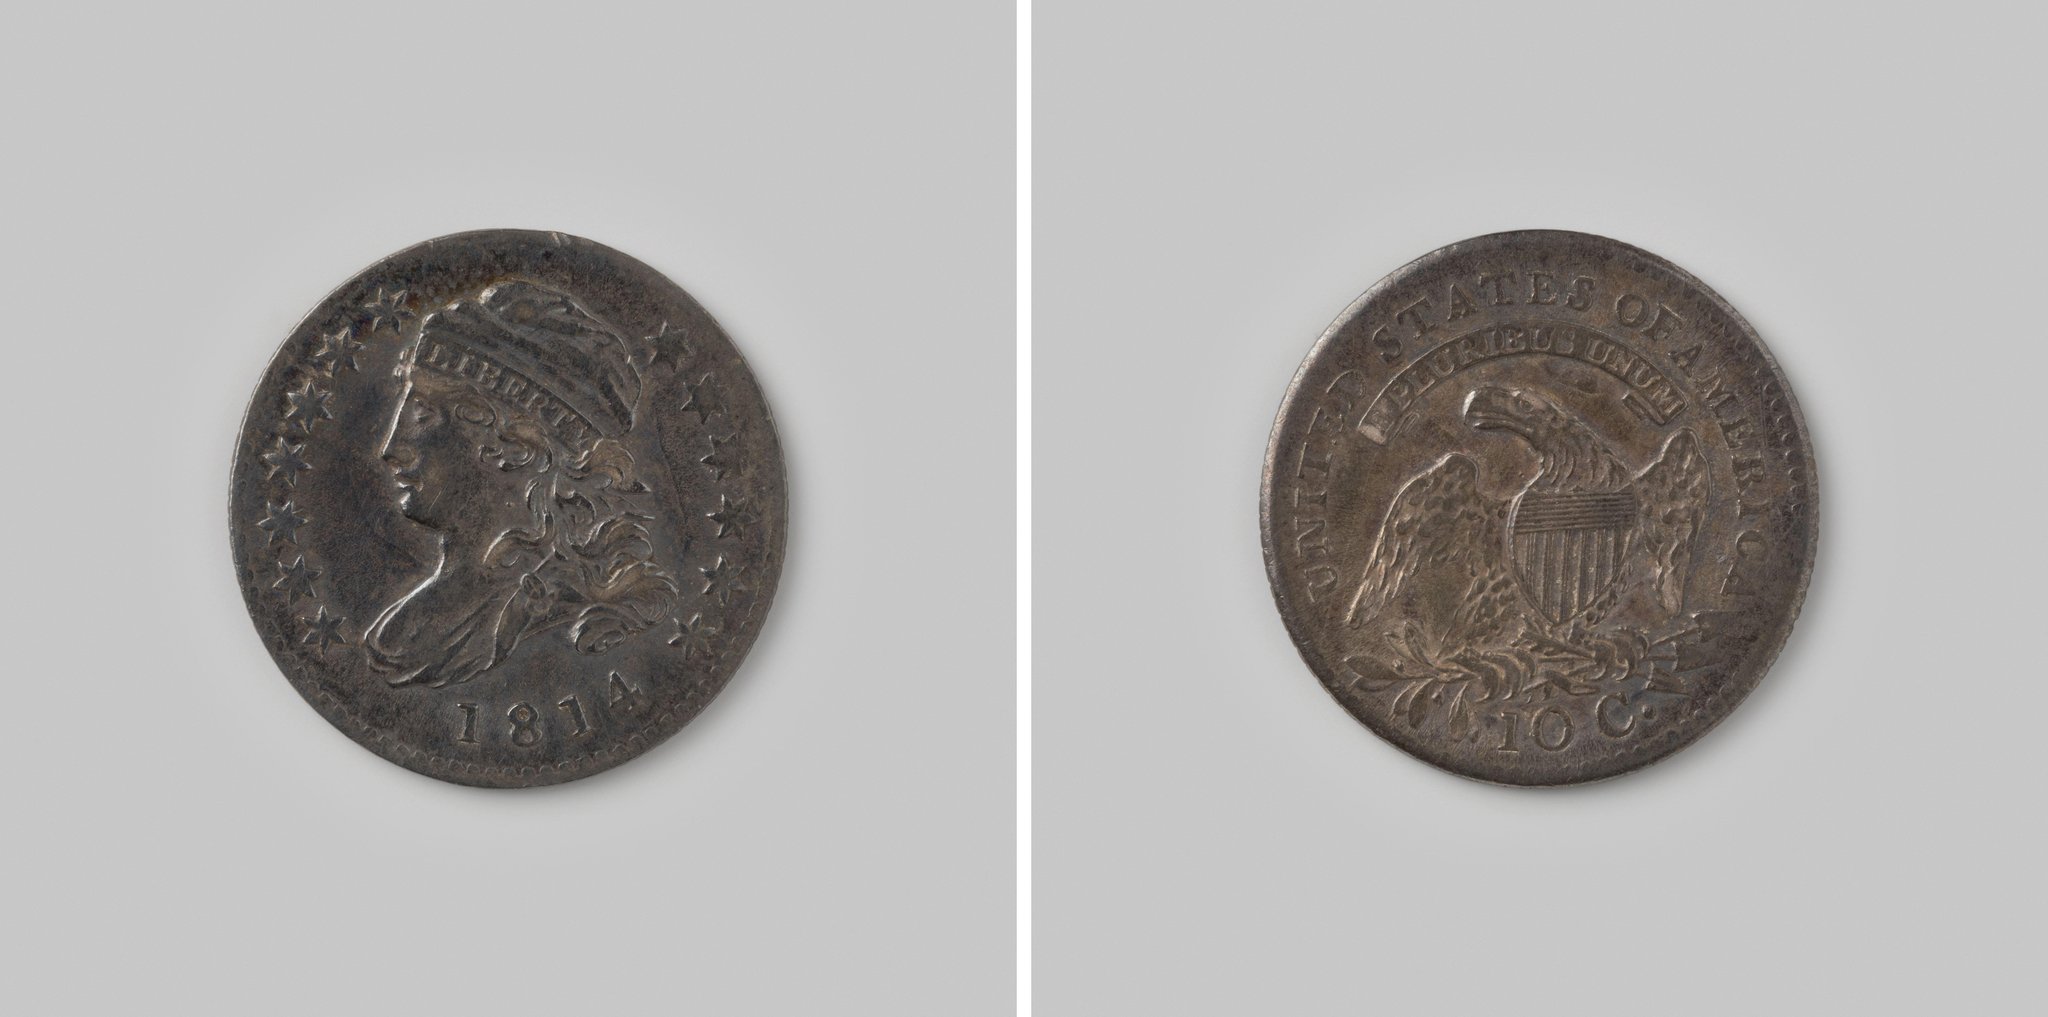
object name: coin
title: Dime of 10 cents uit de Verenigde Staten van Amerika, 1814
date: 1814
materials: silver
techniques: striking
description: Zilveren munt. Voorzijde: liberty naar links, Daaromheen sterren. Jaartal onderaan. Keerzijde: adelaar met gespreide vleugels met in zijn rechter klauw tak en in zijn linker klauw pijlenbundel en op zijn borst wapenschild, omkijkend naar links. Daarboven een banderol met opschrift. Onderaan waarde-aanduiding: 10 C. Kartelrand.